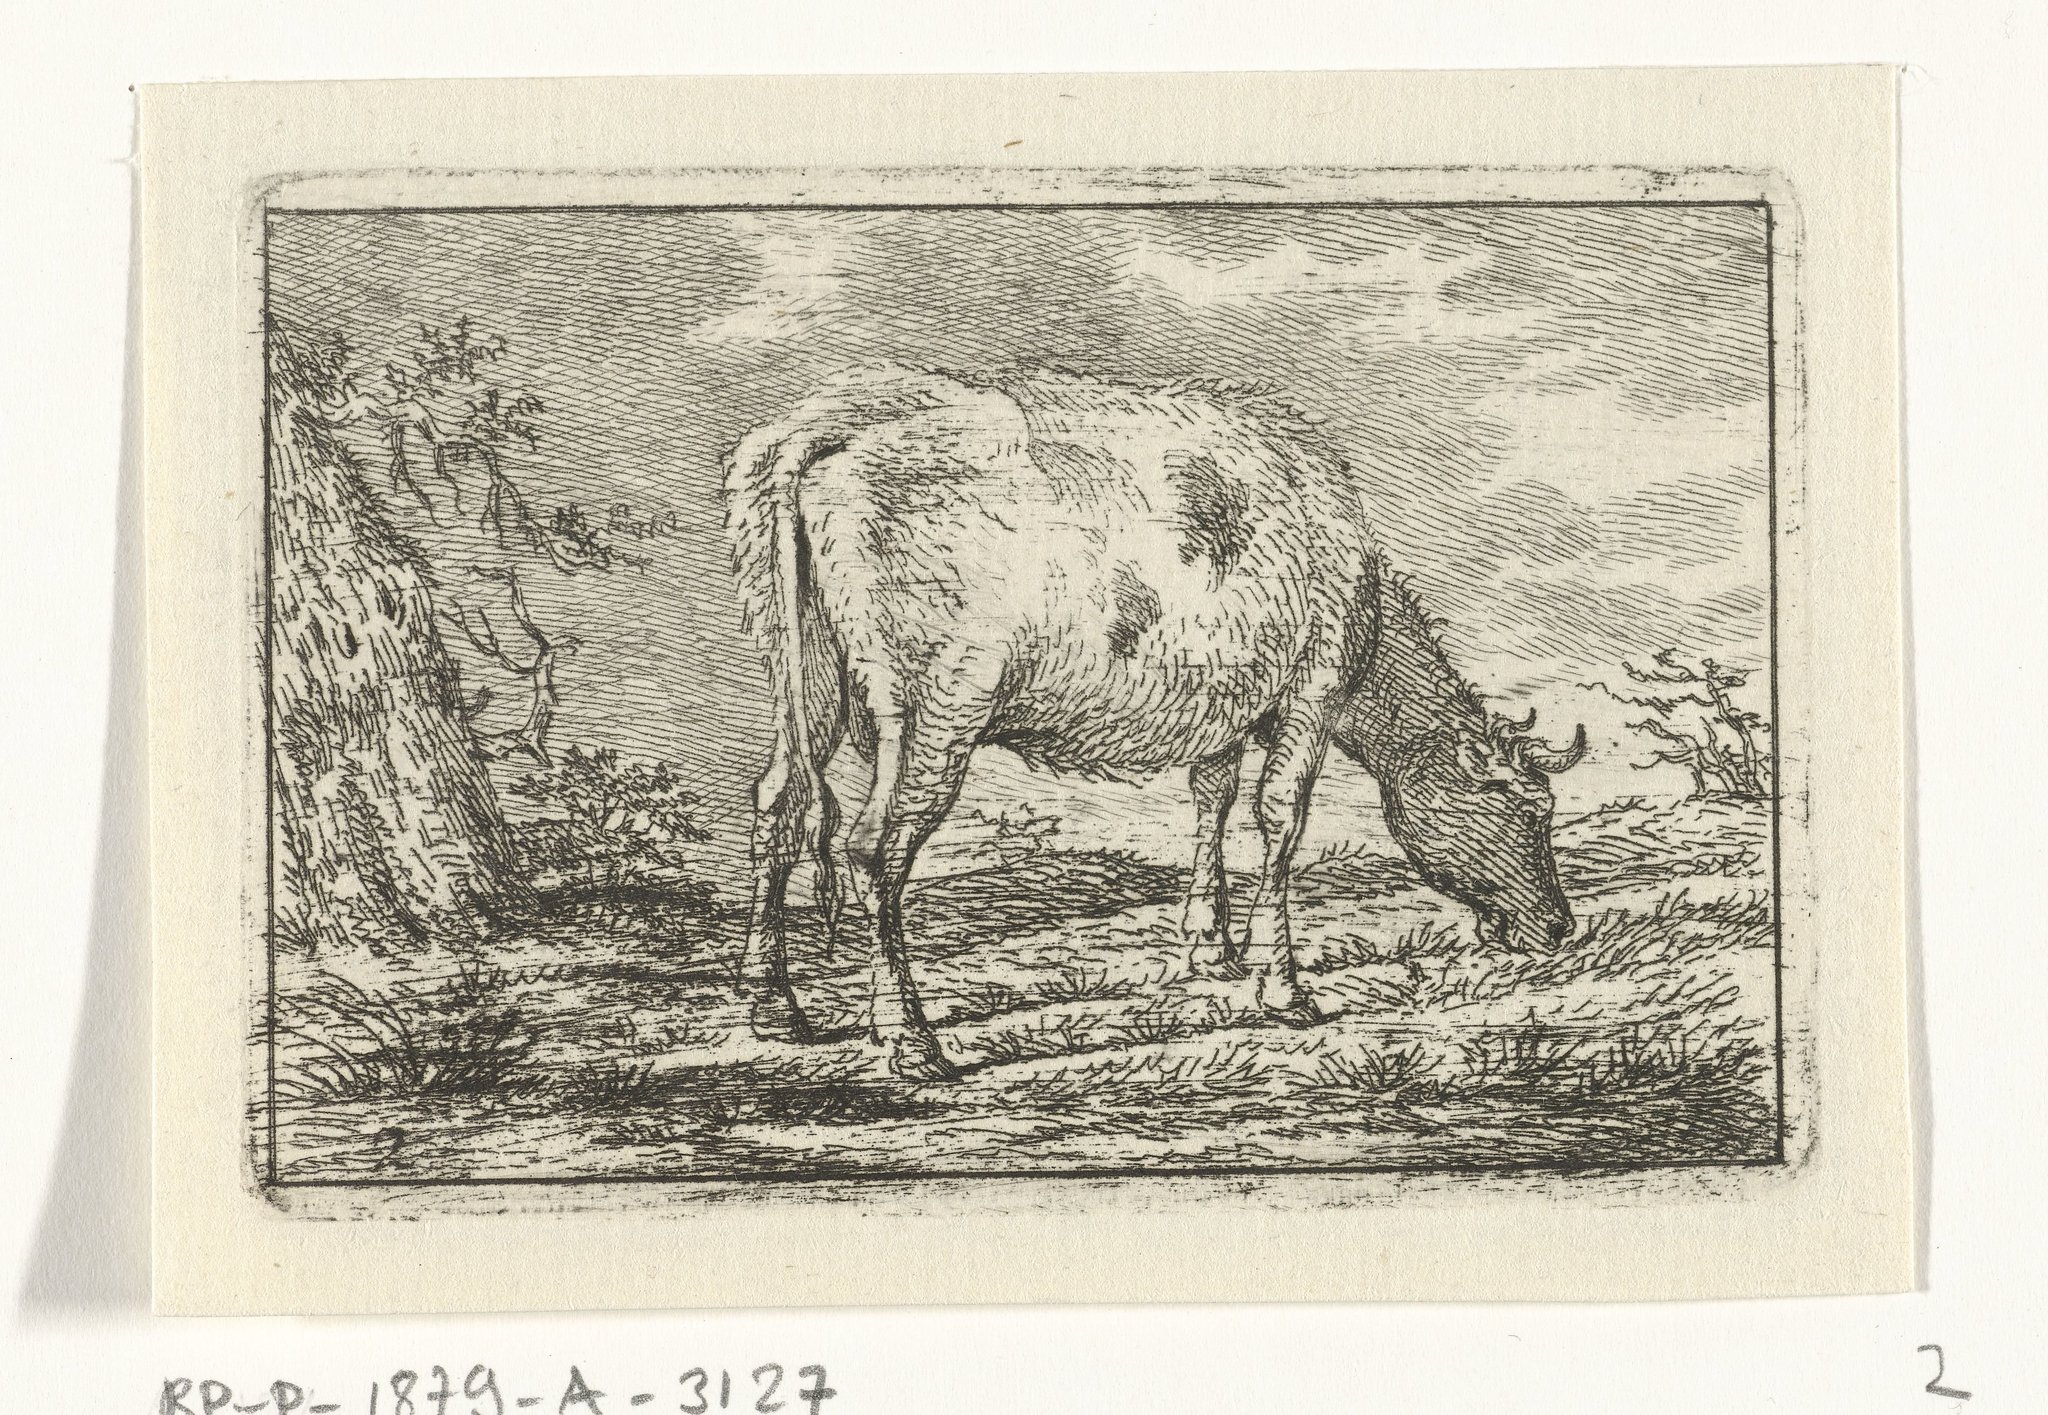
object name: print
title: Koeien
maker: anthony oberman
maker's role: draughtsman, painter, print maker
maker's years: 1781-1845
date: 1796-1845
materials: paper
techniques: etching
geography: amsterdam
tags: bovine cattle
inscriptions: collector's mark: Lugt 2228